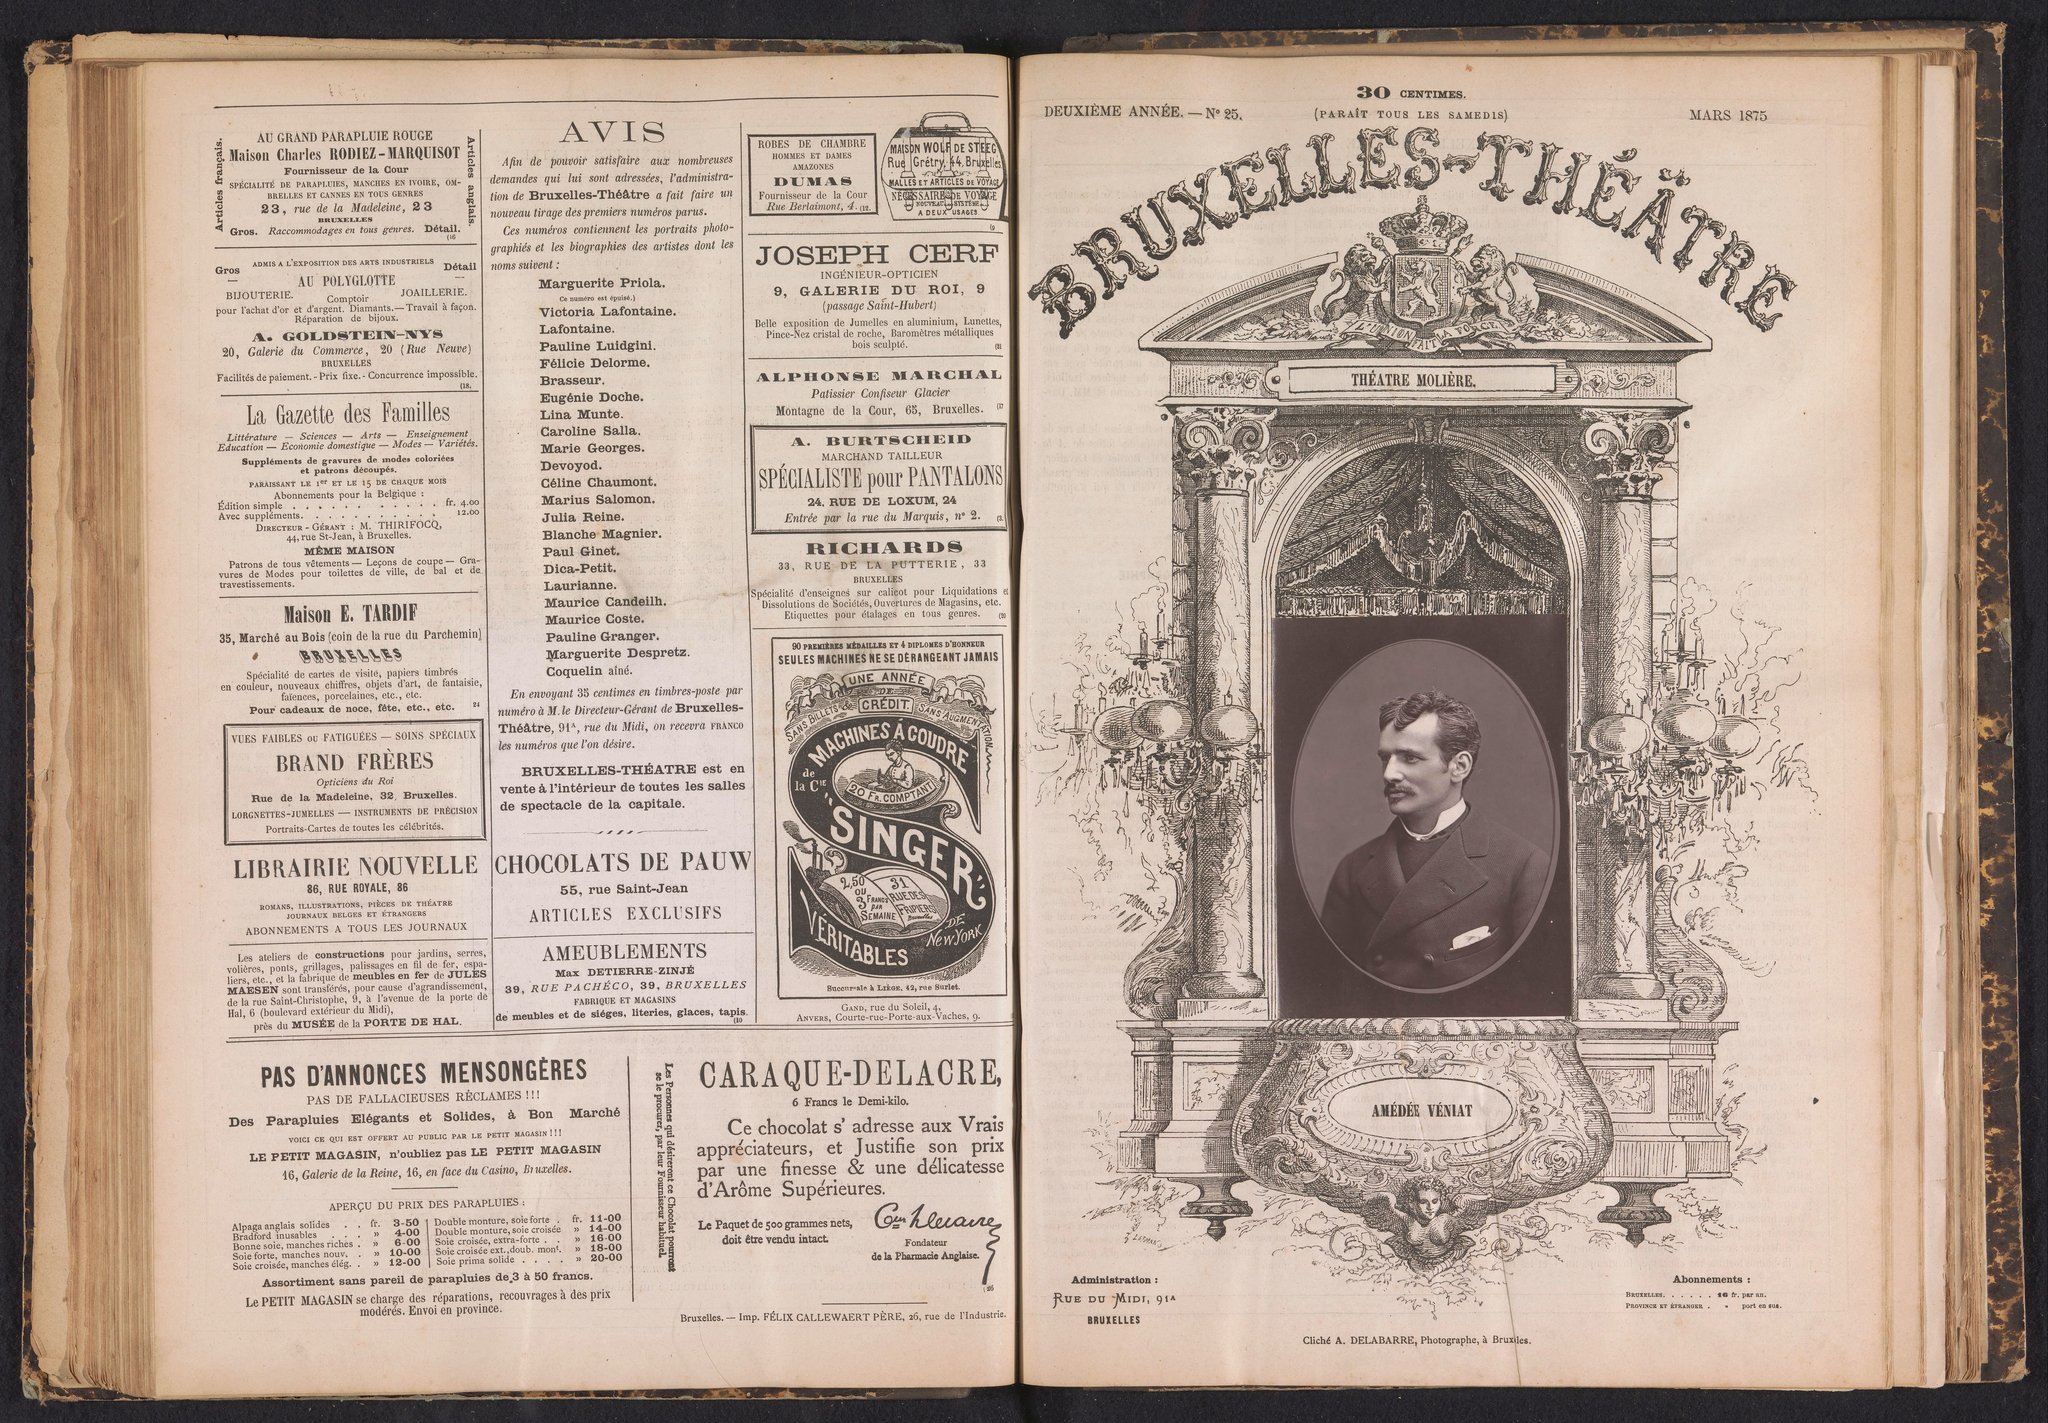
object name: page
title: Portret van Amadée Véniat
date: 1870-1875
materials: paper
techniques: woodburytype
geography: brussels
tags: portrait of actor, actress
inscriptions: number: ‘No 25.’